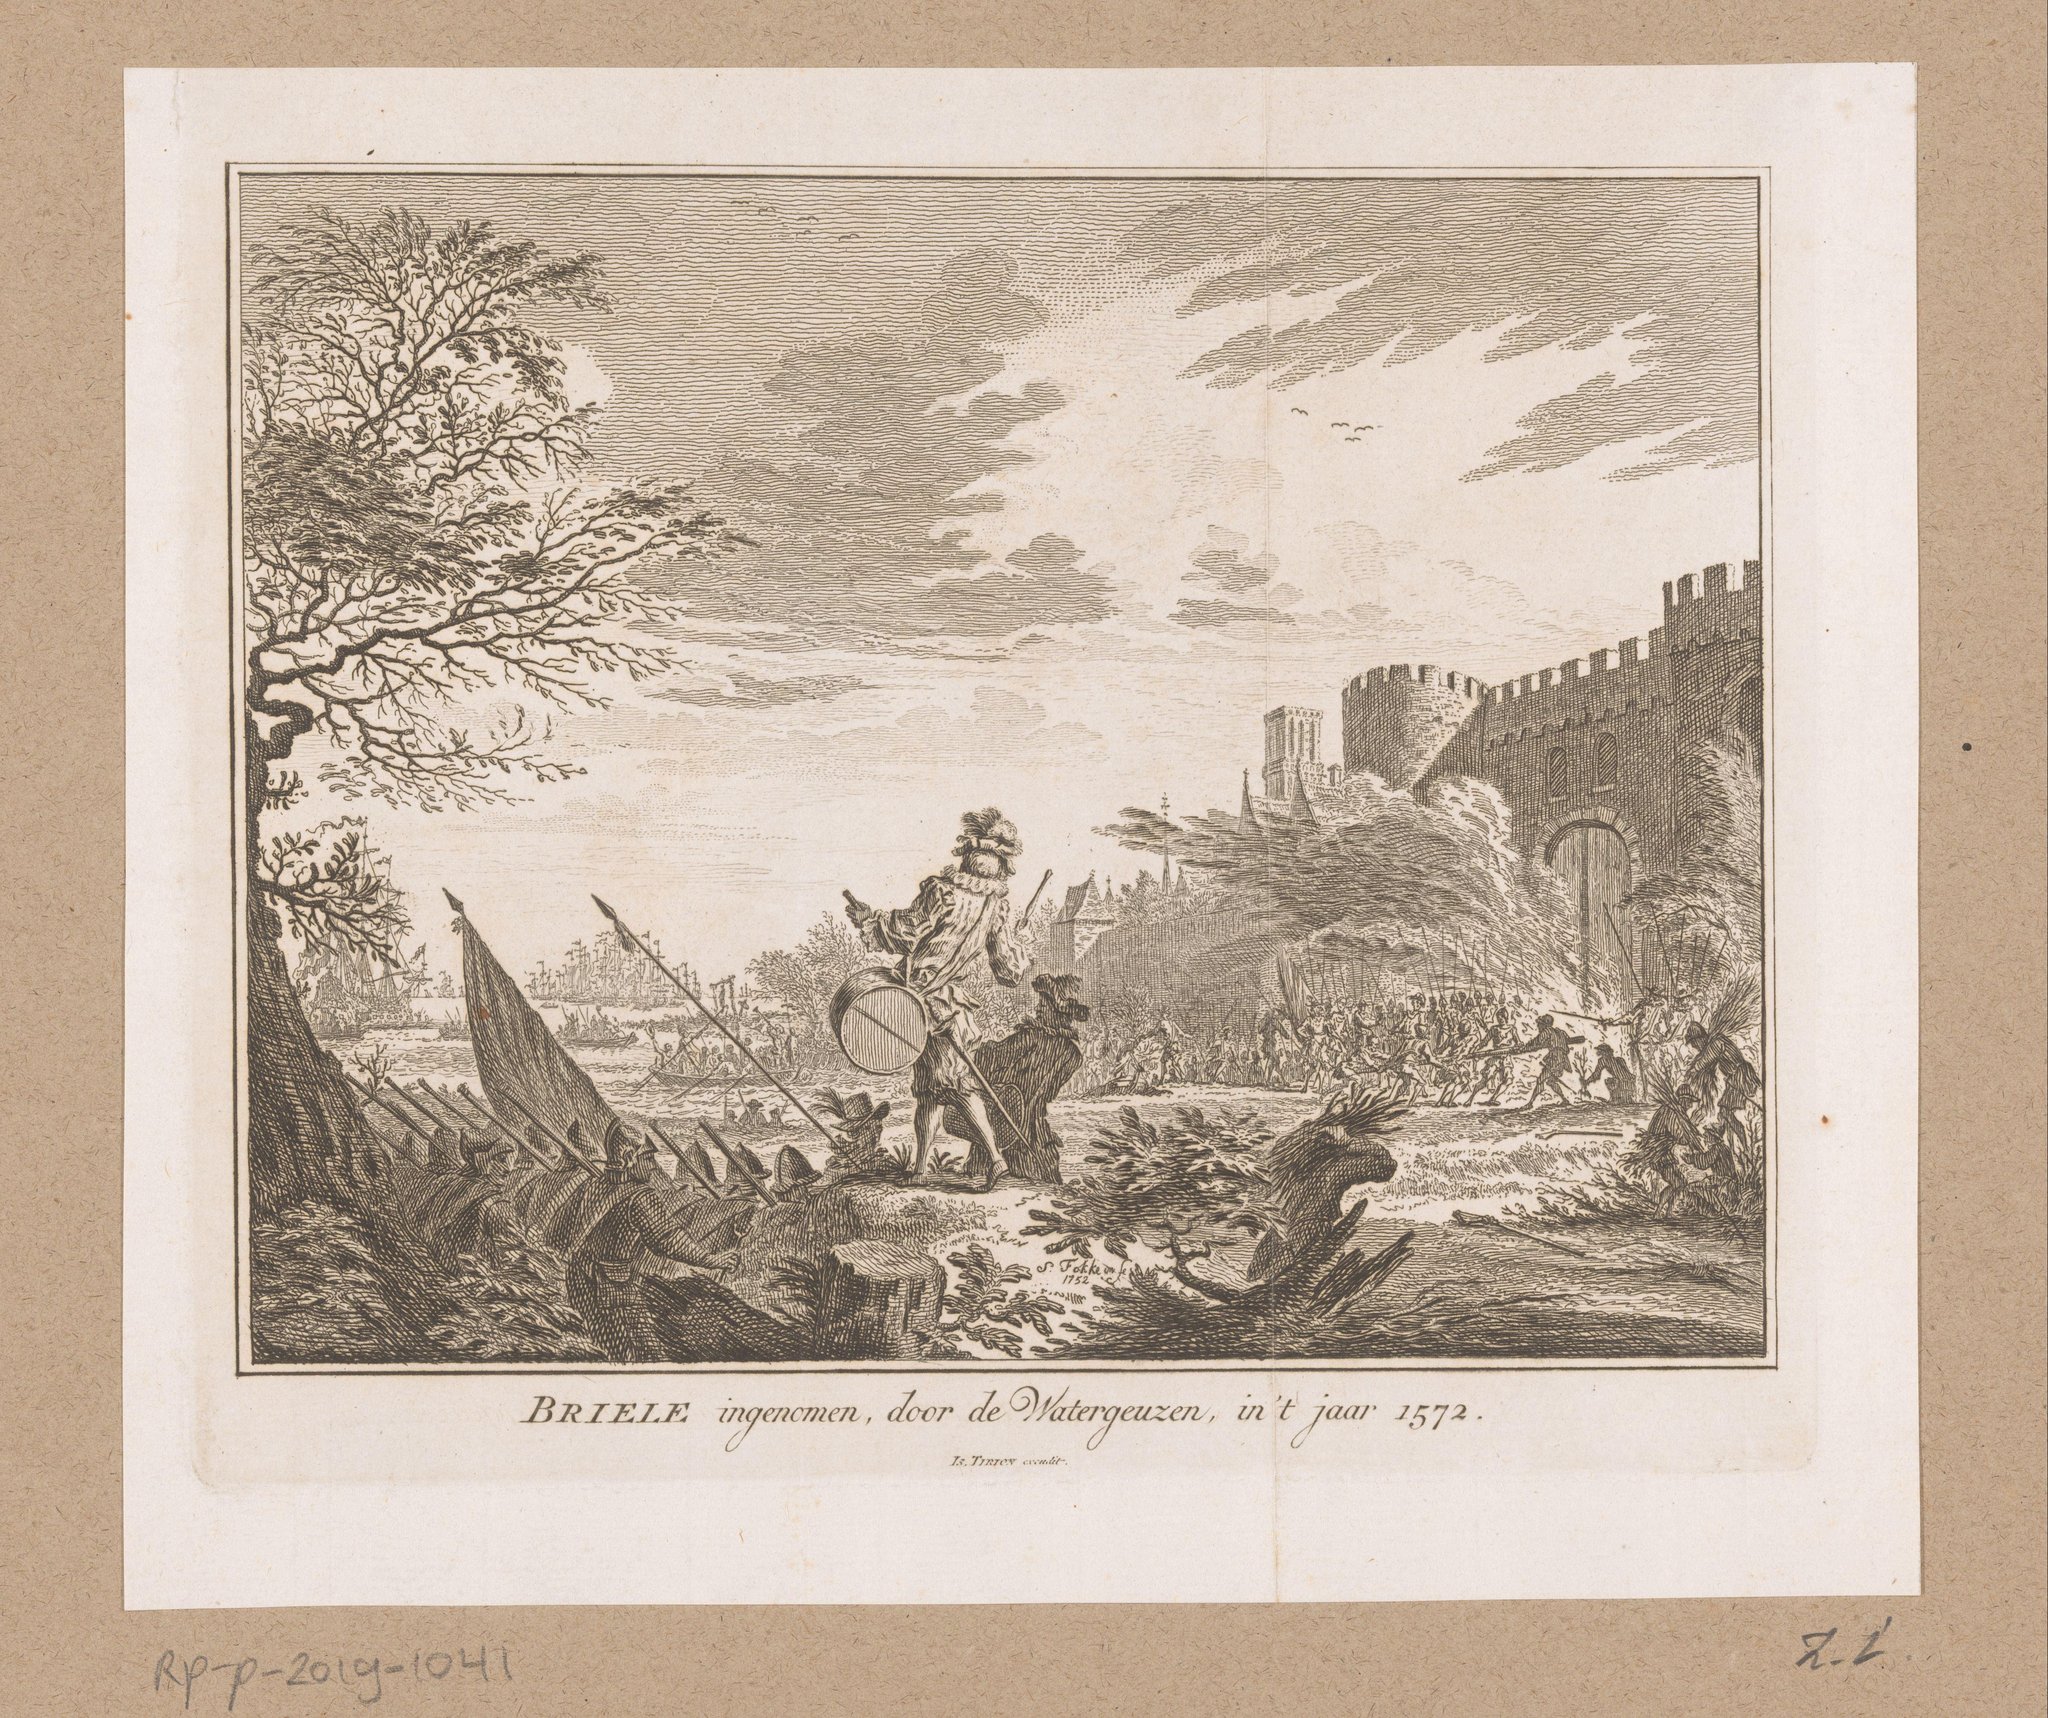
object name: book illustration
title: Inname van Brielle, 1572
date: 1752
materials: paper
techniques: engraving, etching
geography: amsterdam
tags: capture of city (after the siege), brielle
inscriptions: date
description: De watergeuzen van Lumey stichten brand en rammen de stadspoort van Brielle, 1 april 1572. Op de voorgrond twee trommelaars en een vendel soldaten. Op de achtergrond schepen in het water.